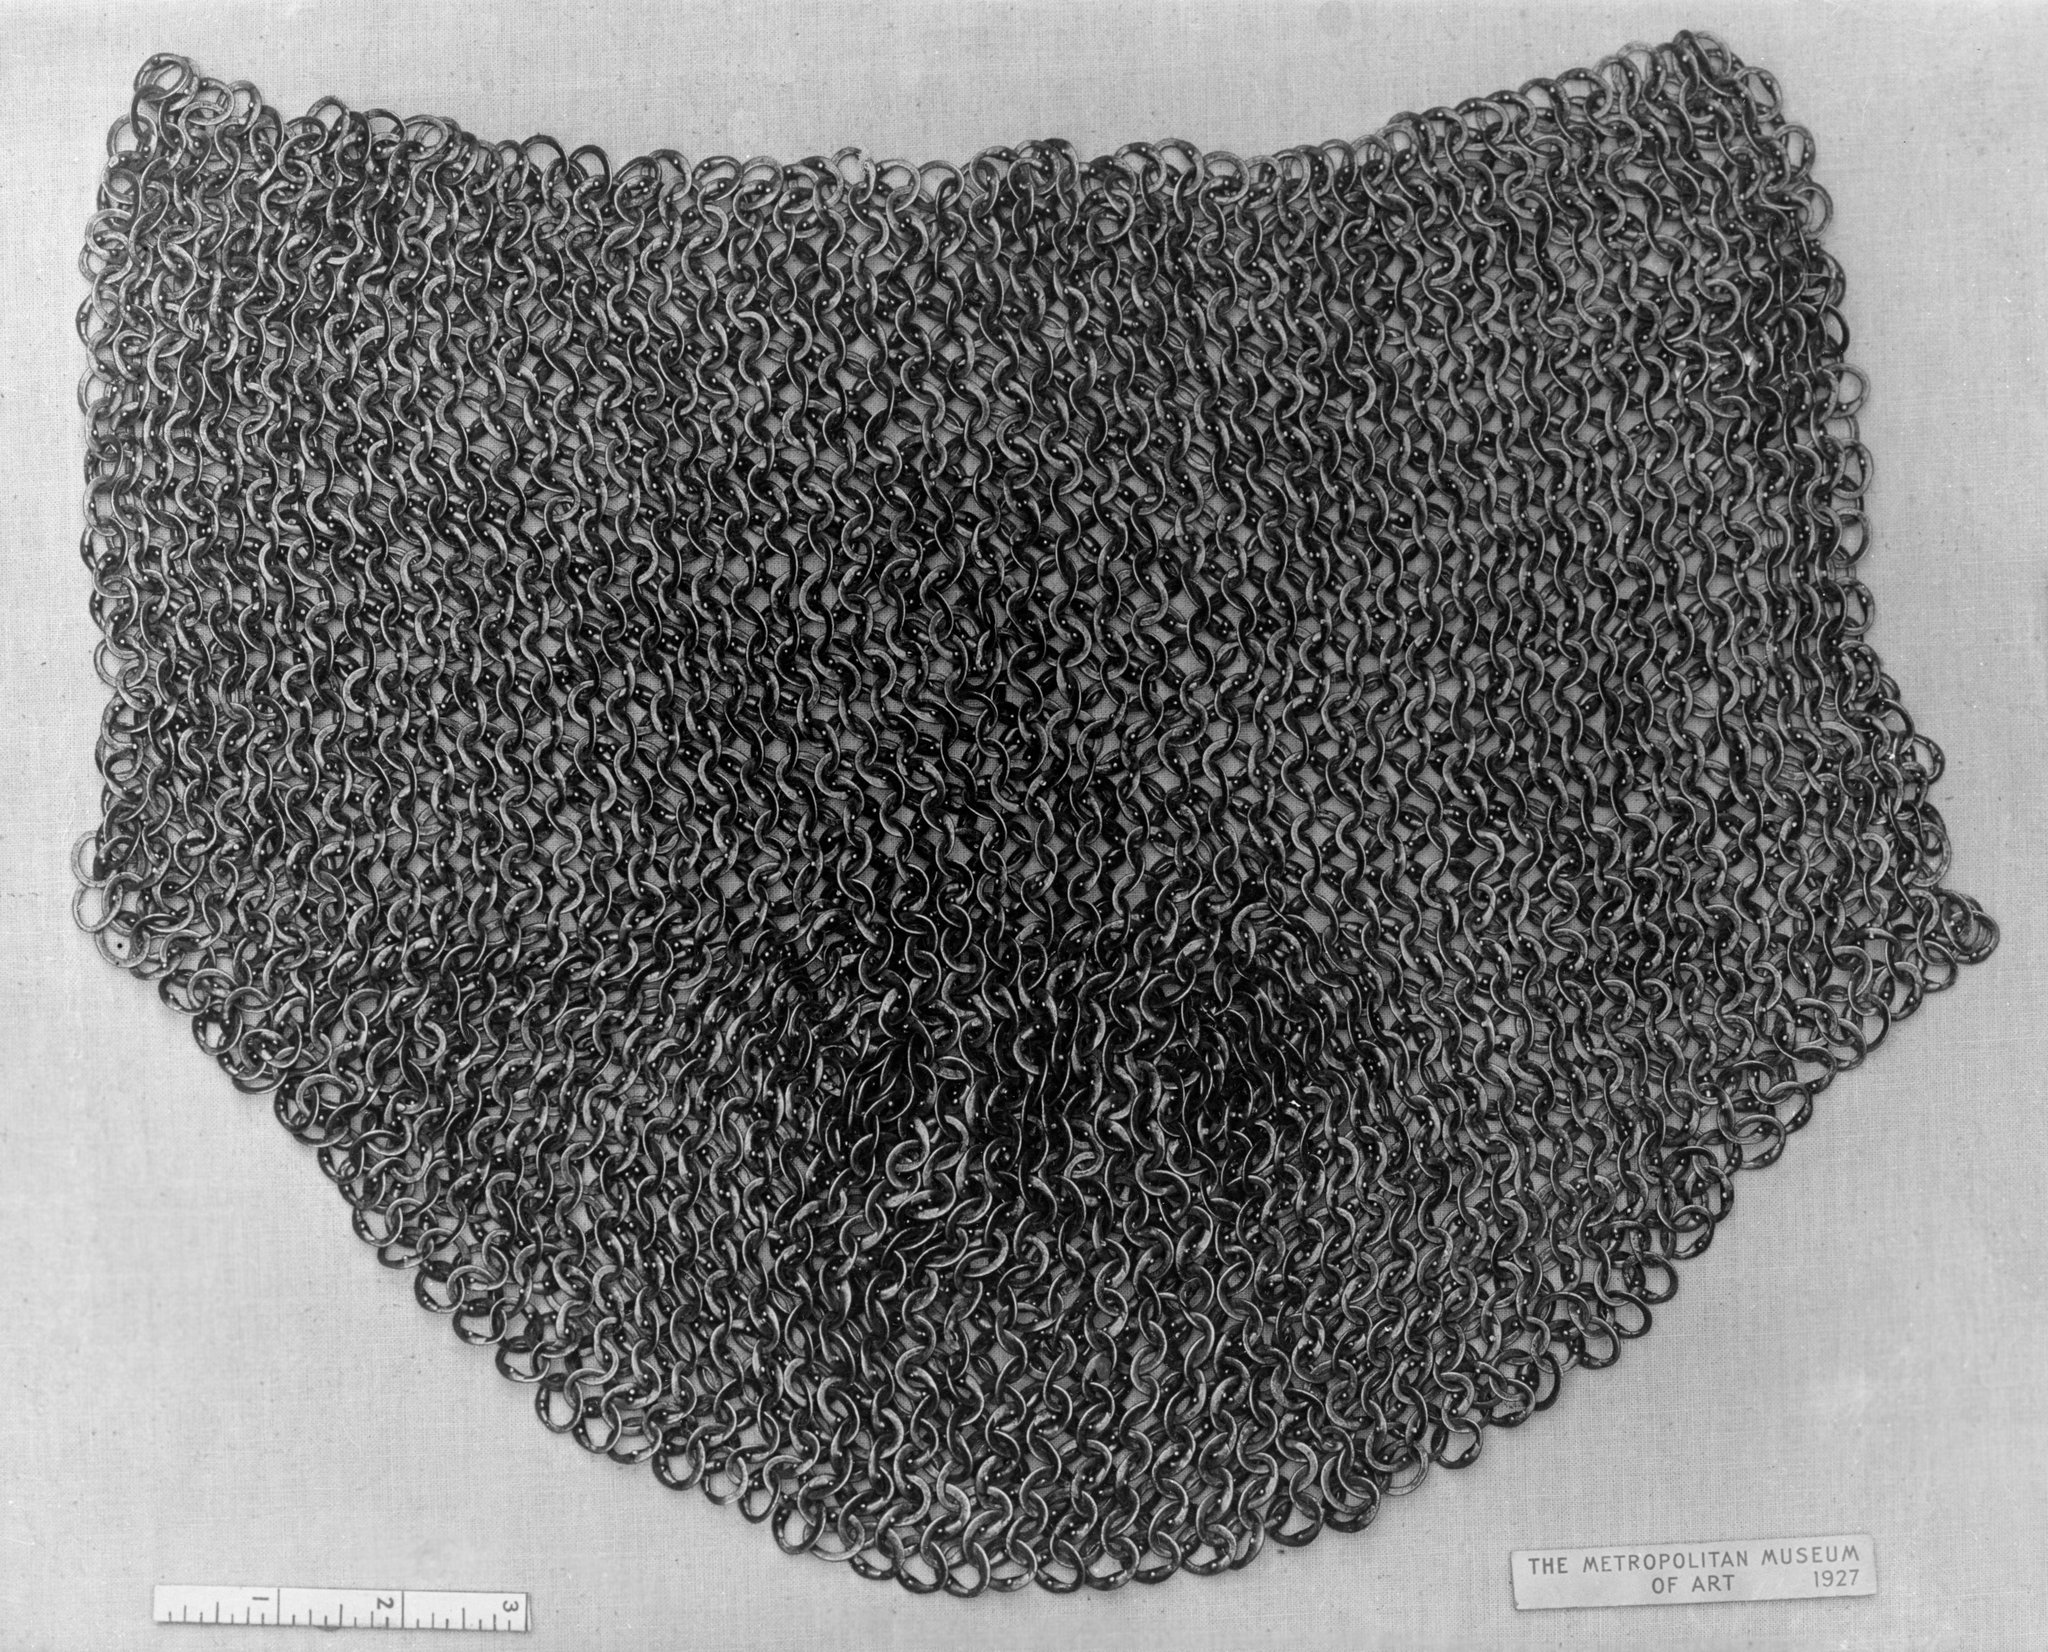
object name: mail brayette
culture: german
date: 1501-1600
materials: steel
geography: germany